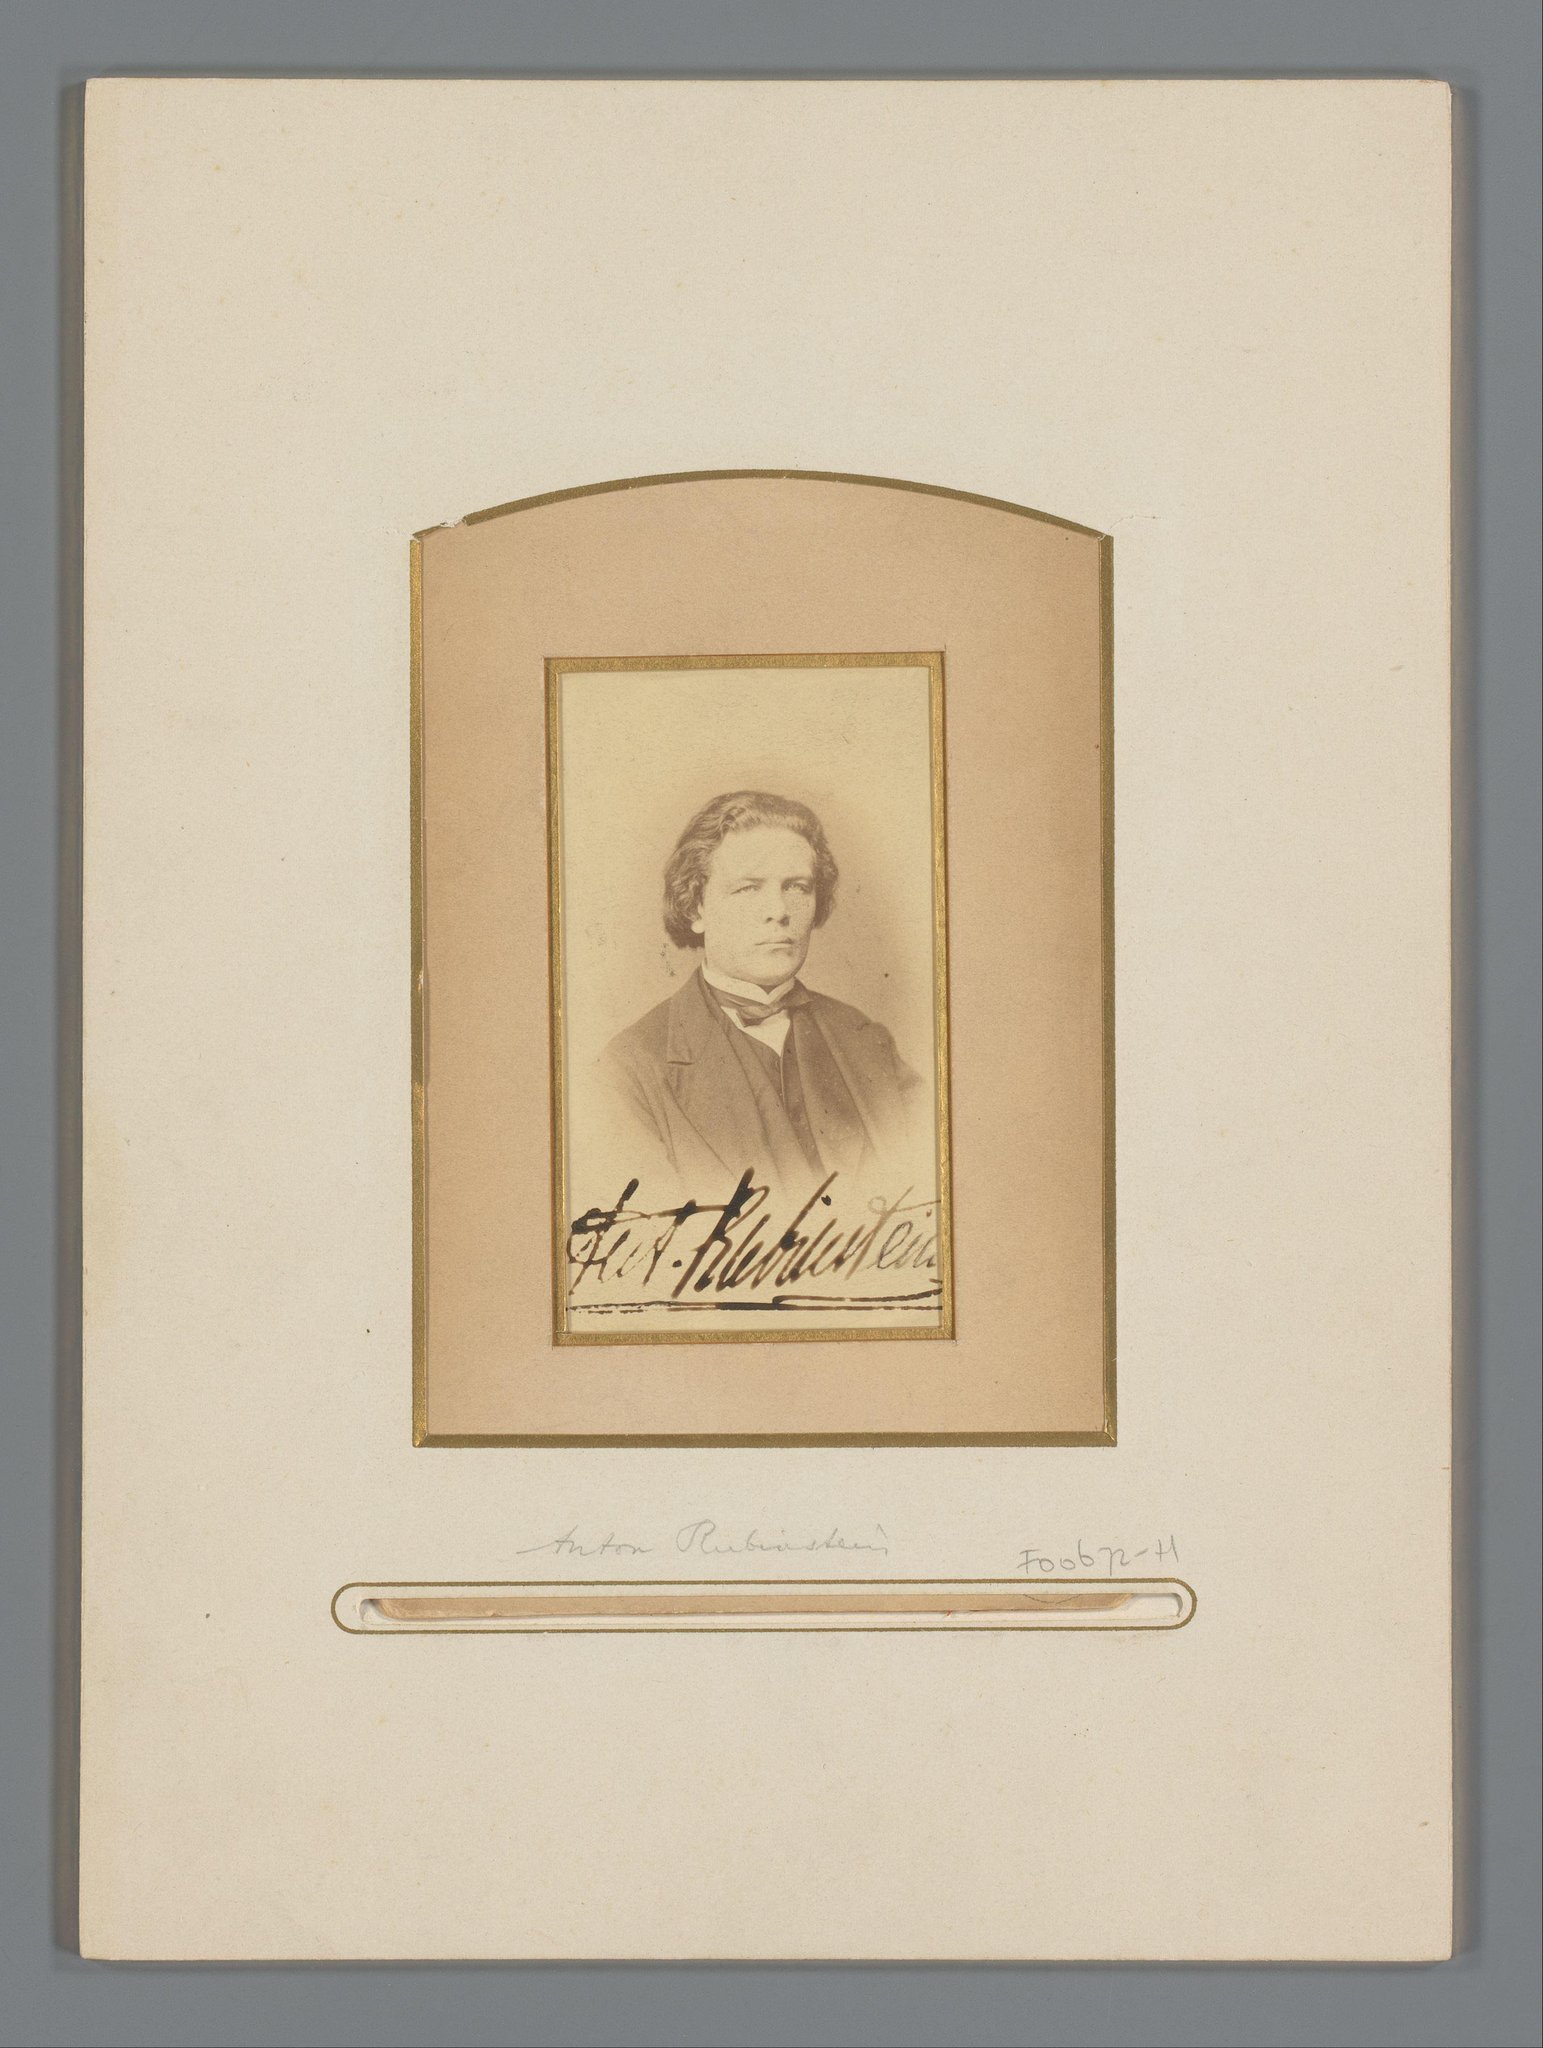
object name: cabinet photograph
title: Portret van pianist Anton Rubinstein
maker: josef löwy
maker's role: publisher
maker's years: 1835-1902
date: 1870-1875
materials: cardboard, photographic support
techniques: albumen print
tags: adult man, historical persons, portrait of a musician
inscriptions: signature: ‘A. Rubinstein’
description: Deze foto maakt deel uit van een omslag met 22 foto's.